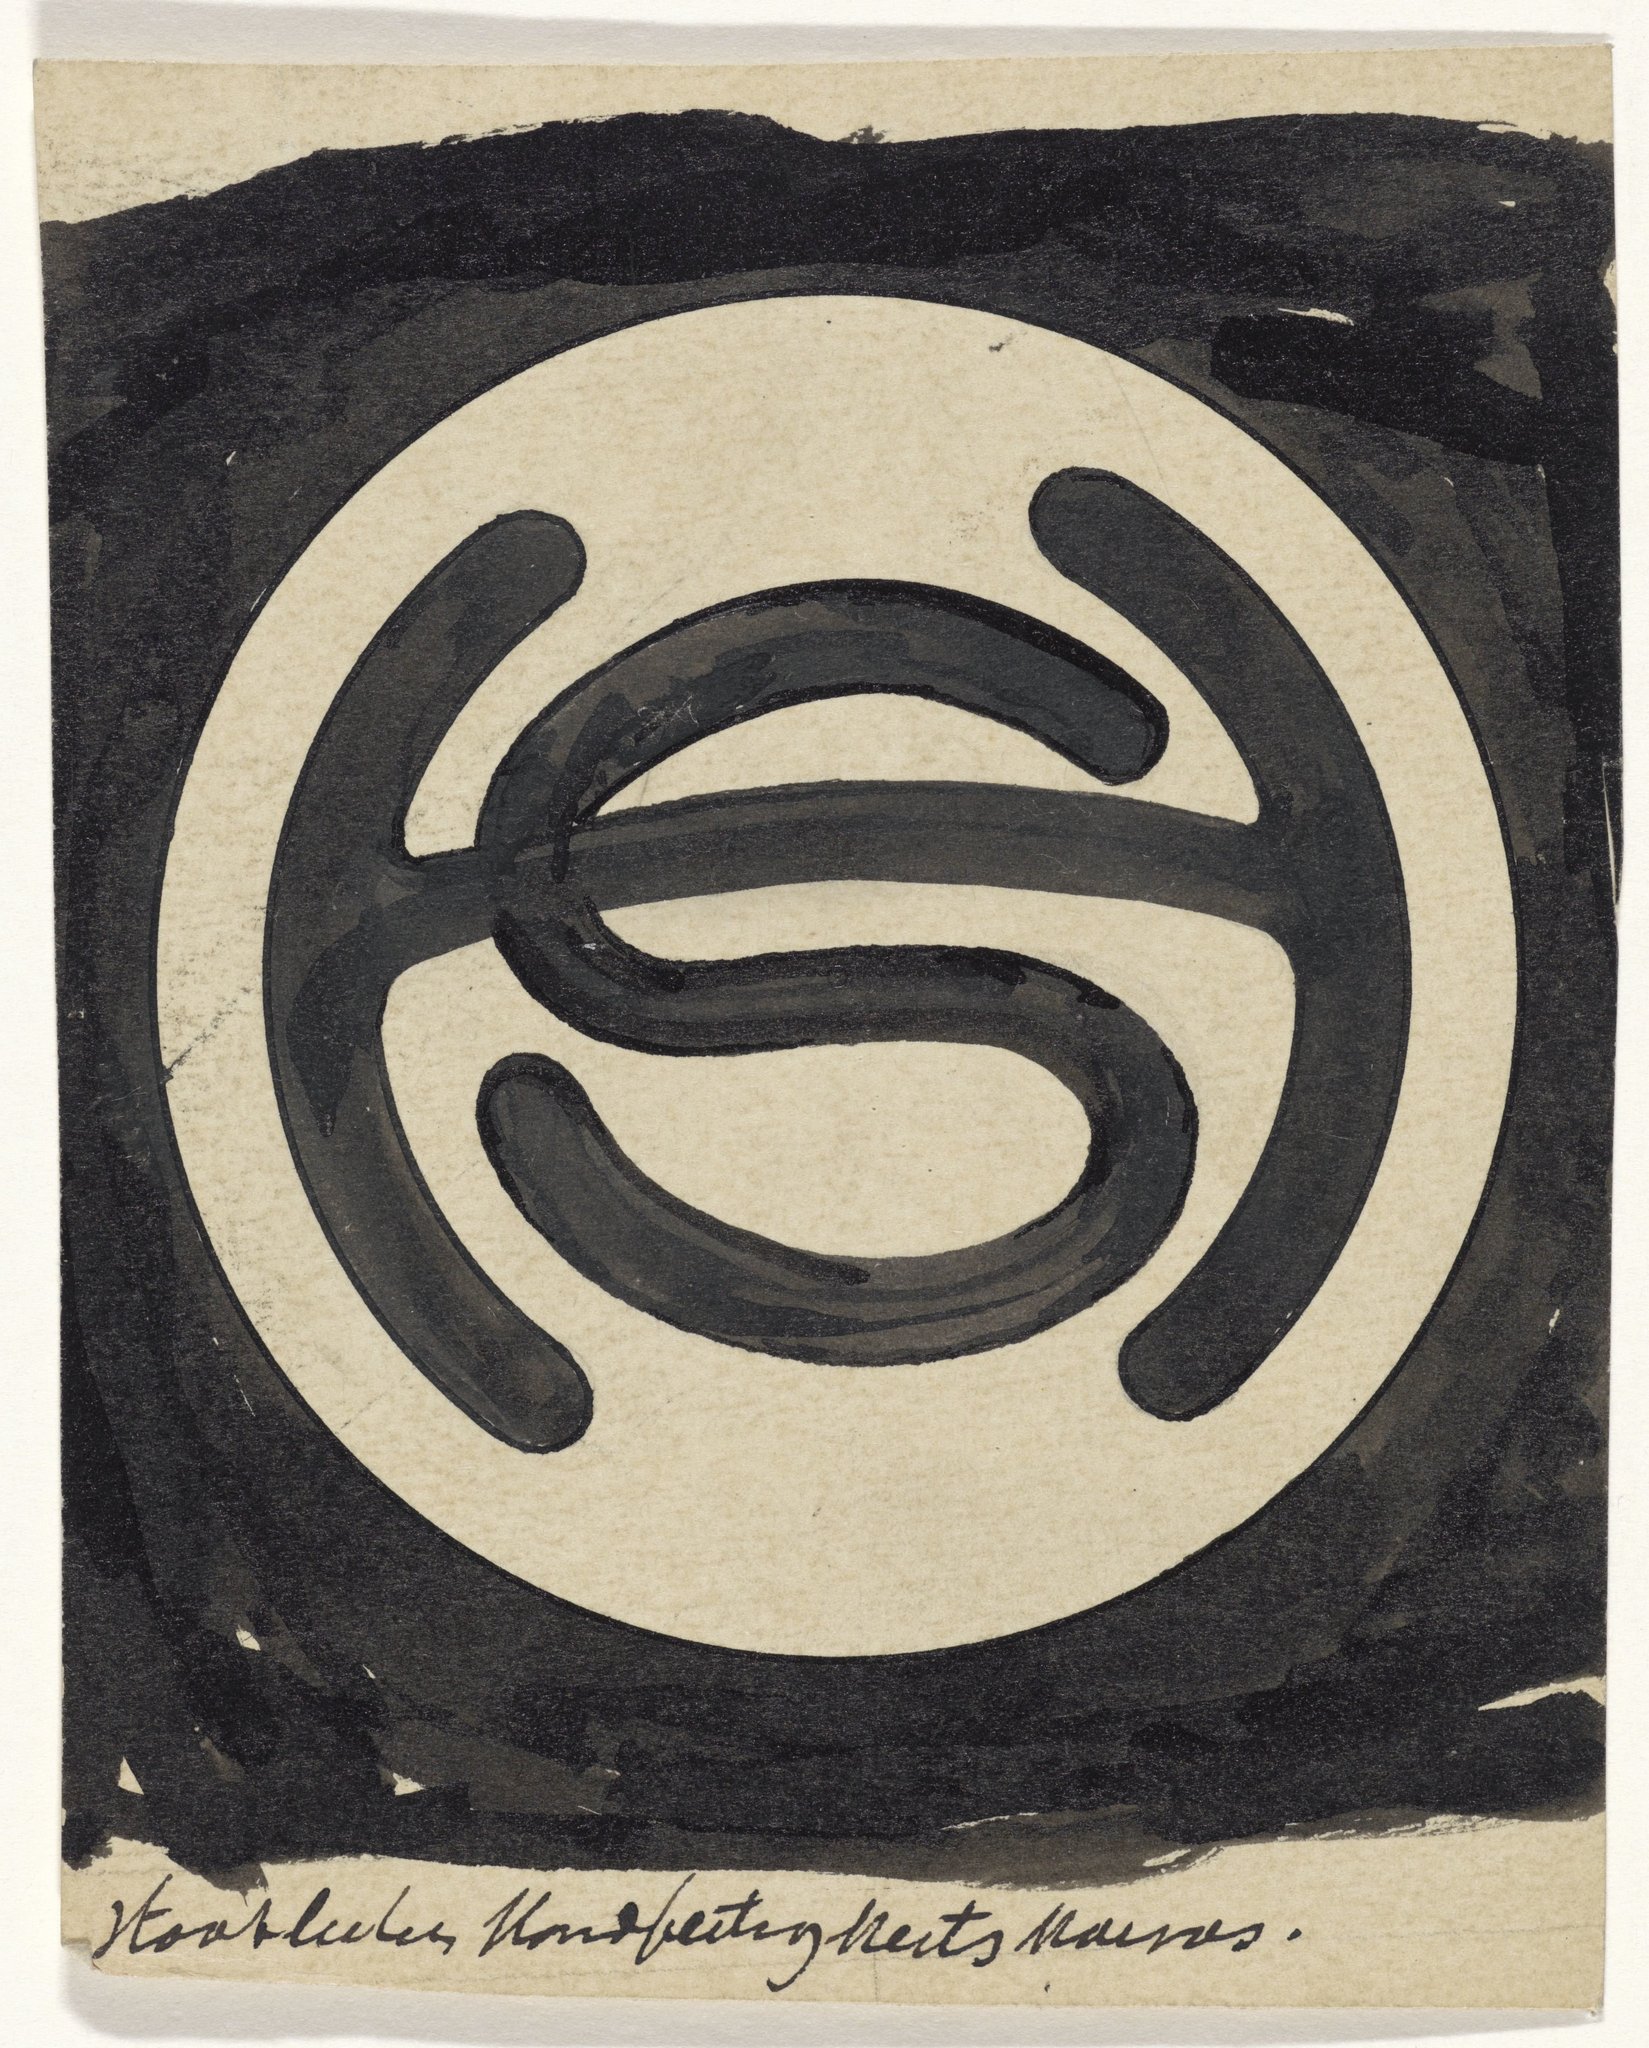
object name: design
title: Ontwerp voor een sieraad met de initialen H.S.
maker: mathieu lauweriks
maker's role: designer, draughtsman, print maker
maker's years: 1864-1932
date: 1874-1932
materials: paper, pencil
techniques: brush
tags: ornaments, jewels